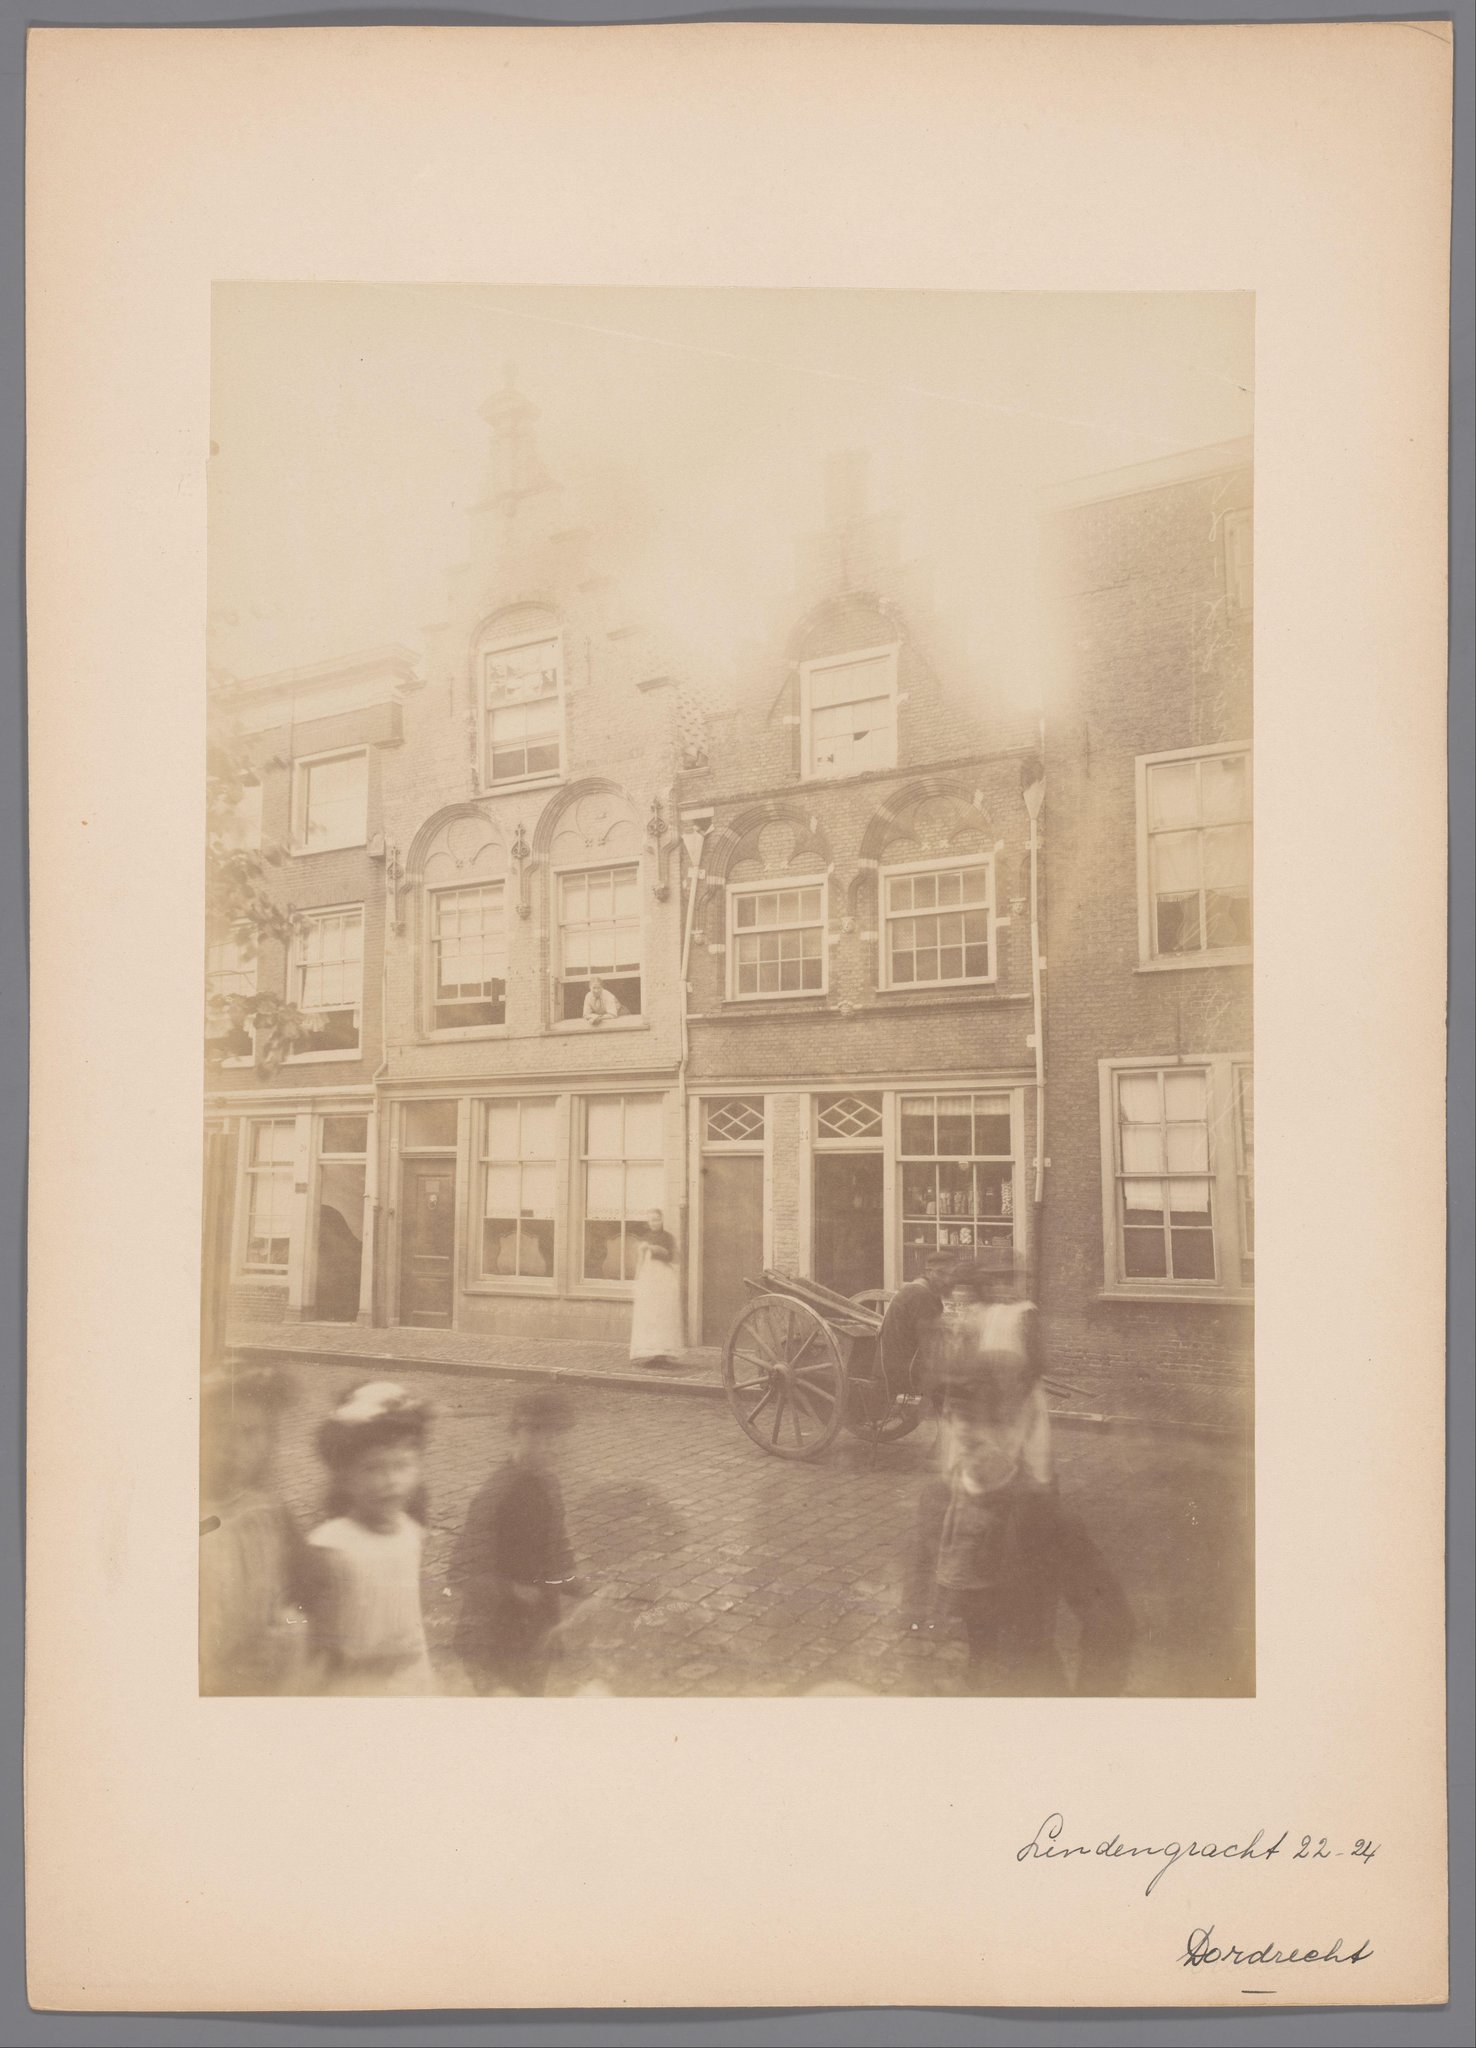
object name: photograph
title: Panden Lindengracht 22-24 te Dordrecht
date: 1890-1910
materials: cardboard, photographic support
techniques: albumen print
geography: lindengracht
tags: urban housing, façade (of house or building), street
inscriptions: annotation: ‘Lindengracht 22-24’, annotation: ‘Dordrecht/ Lindengracht N: 22-24’